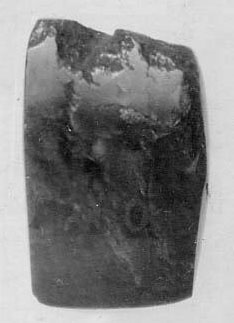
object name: chisel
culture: north american, alaskan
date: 1902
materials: jade